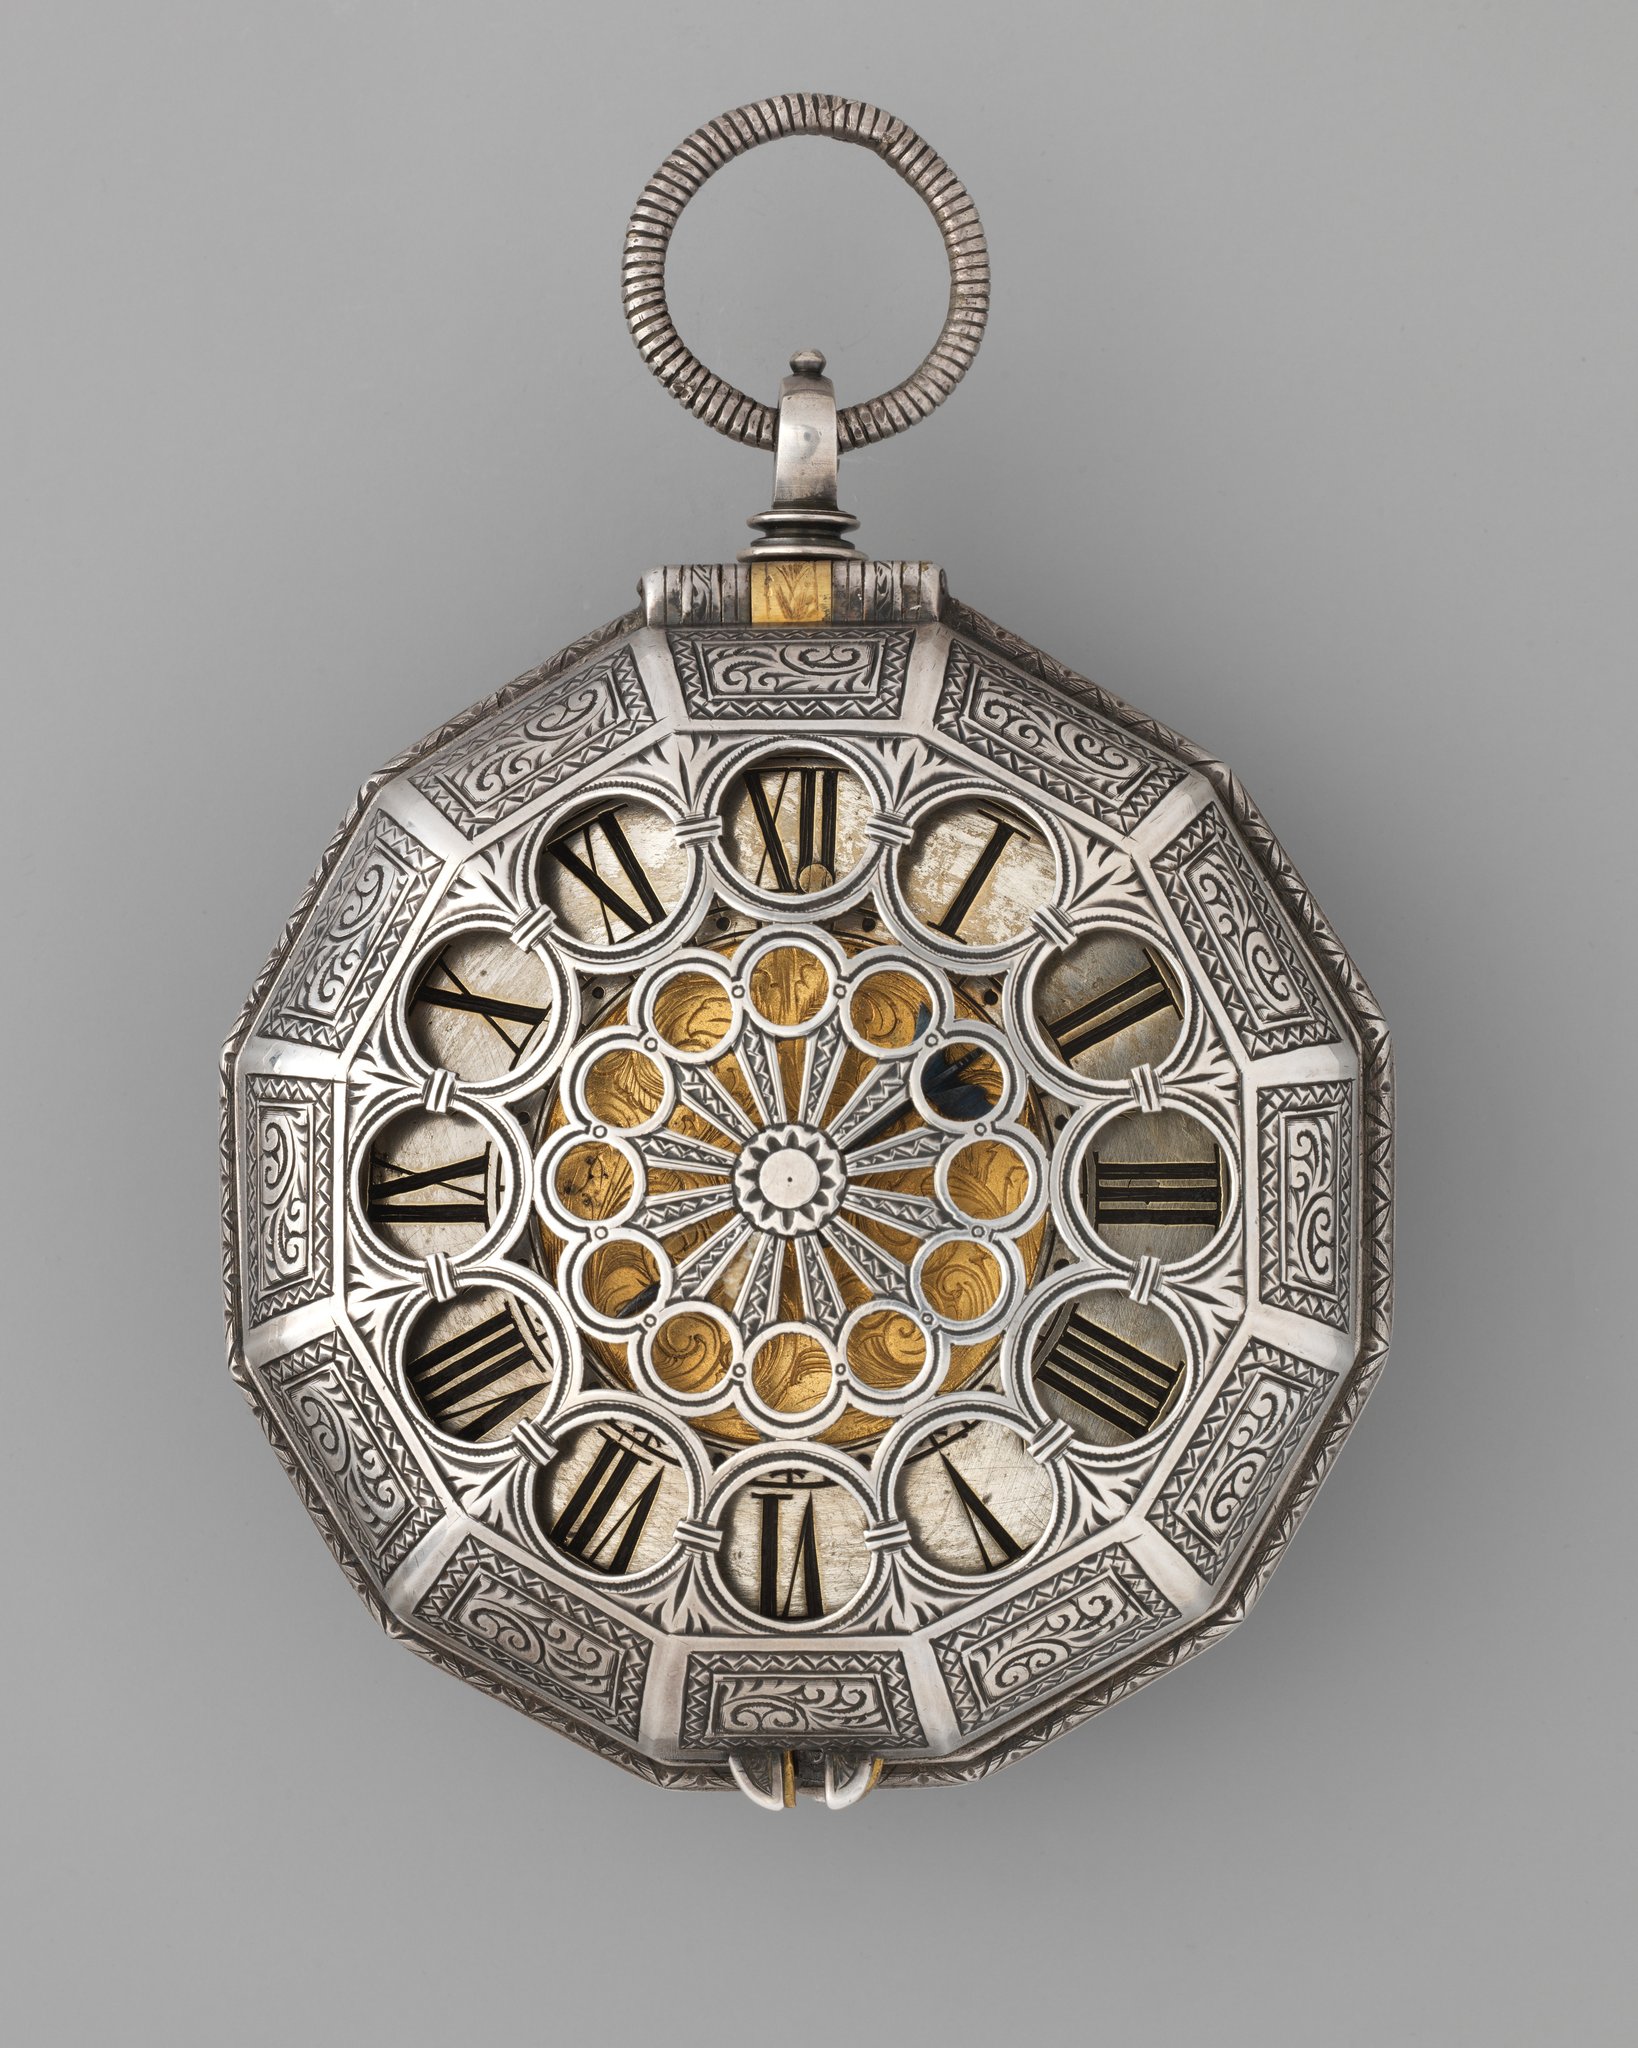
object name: repeater watch with key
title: Repeater watch and key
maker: bartholomew newsam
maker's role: maker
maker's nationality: british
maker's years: 1487-1587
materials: gilt, metal, silver